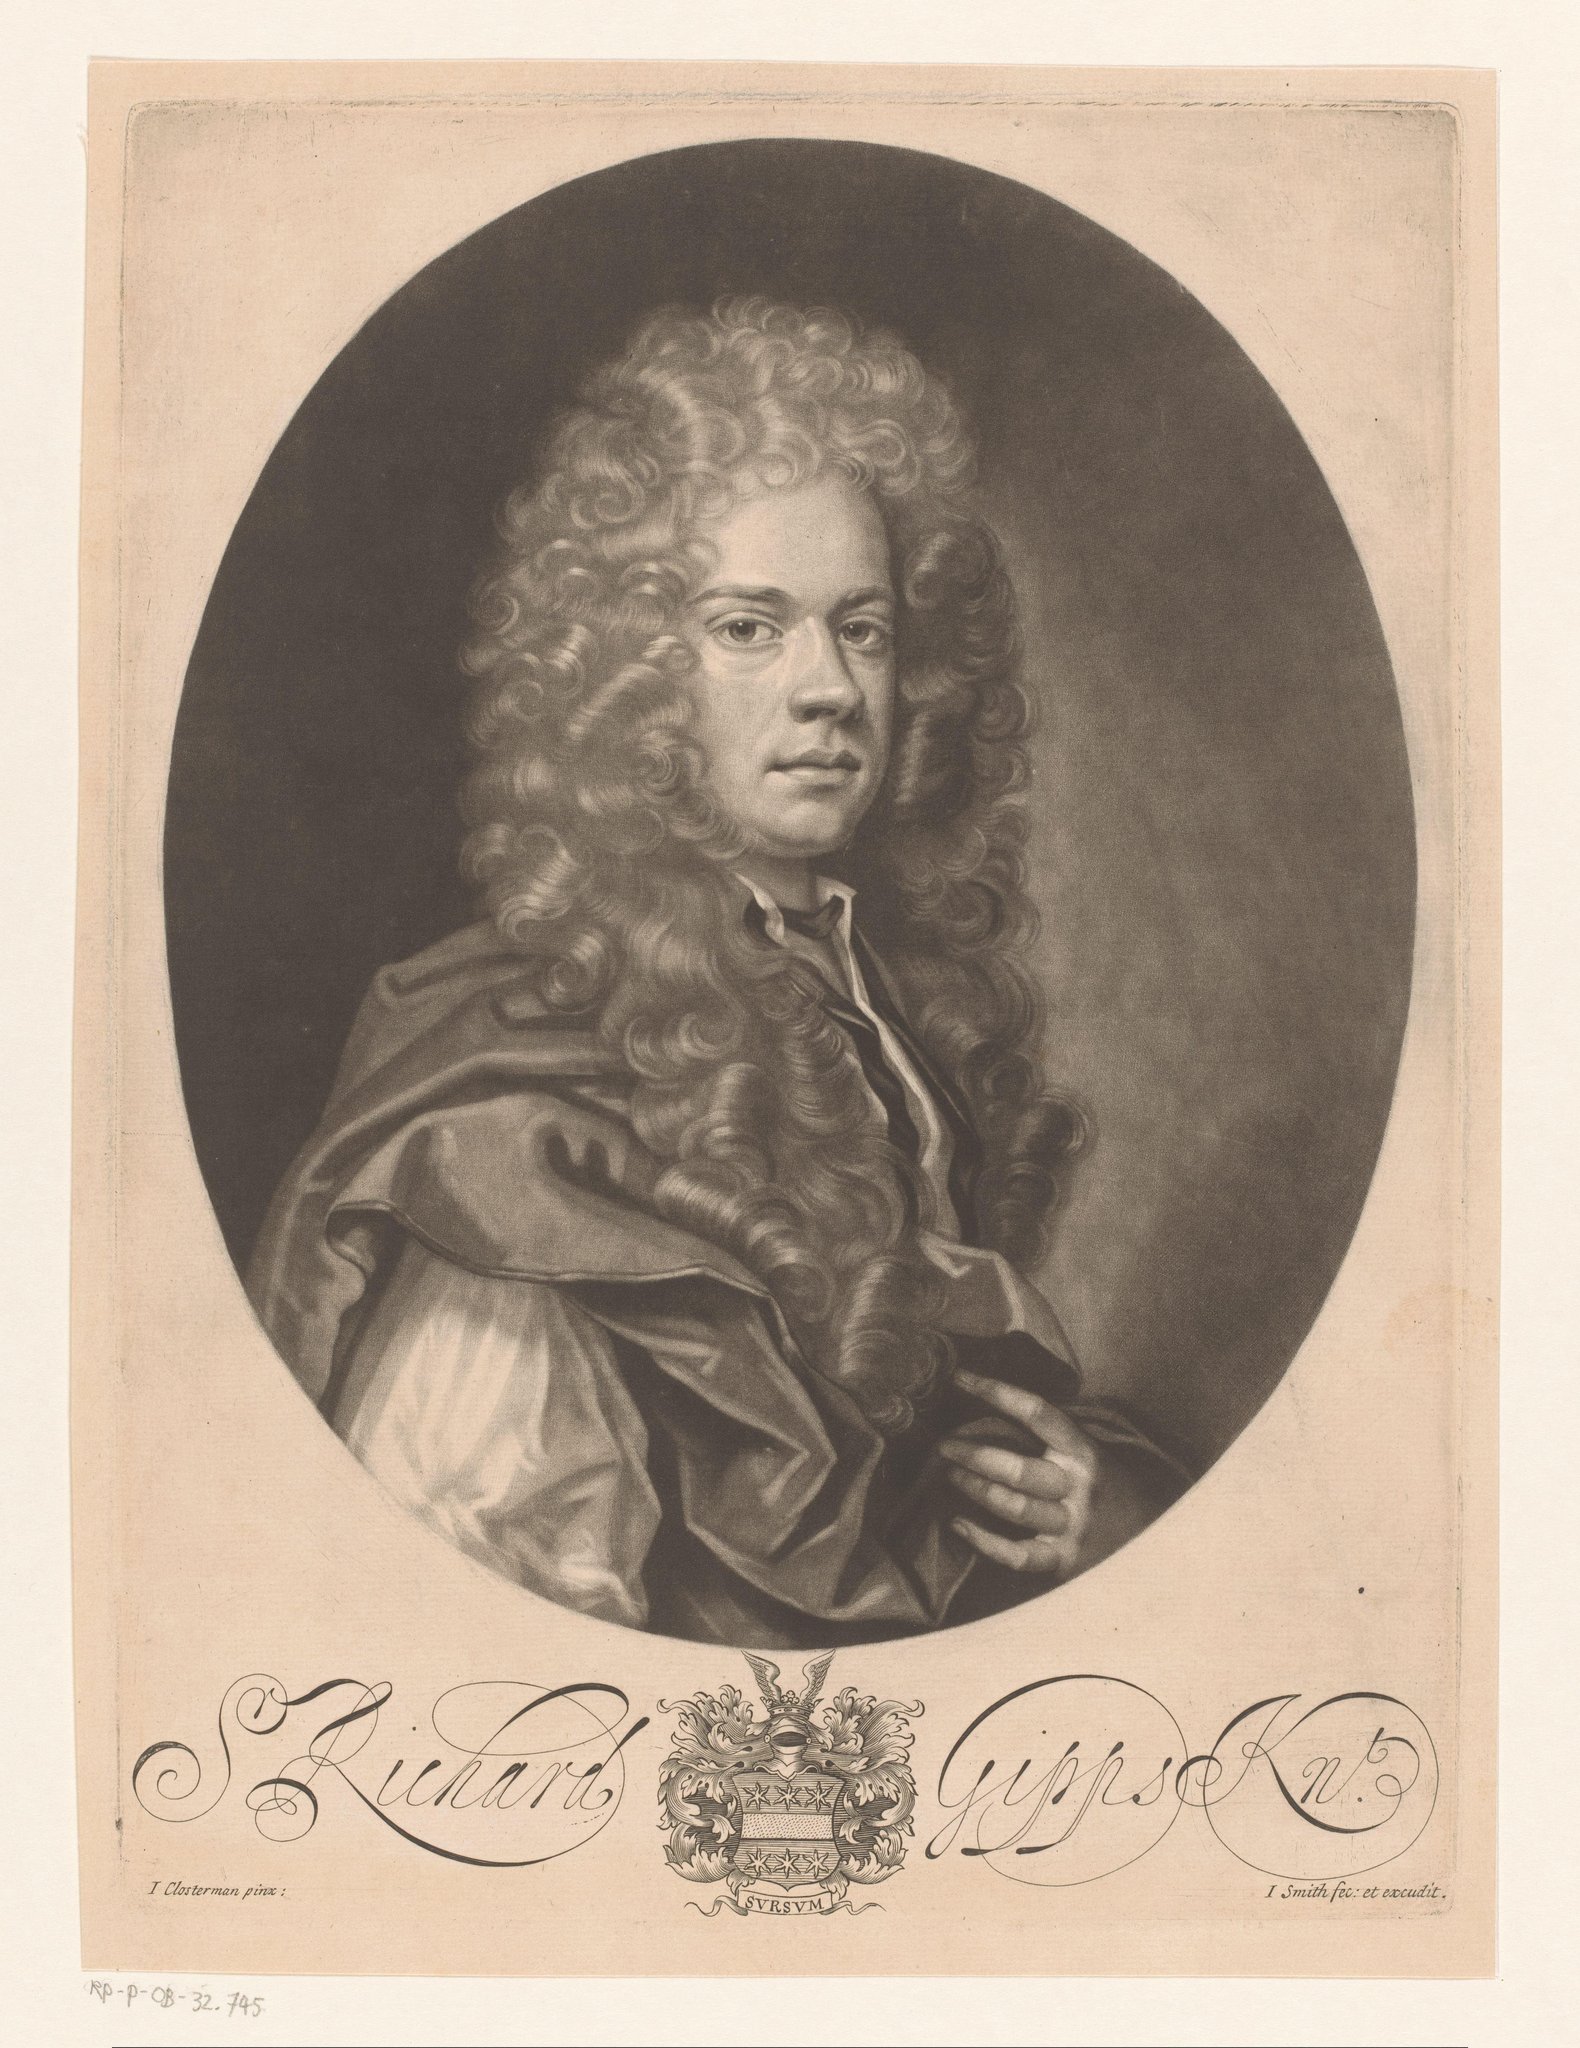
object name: print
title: Portret van Richard Gipps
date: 1669-1742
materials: paper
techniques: mezzotint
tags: historical persons, portrait of a writer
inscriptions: collector's mark: Lugt 240